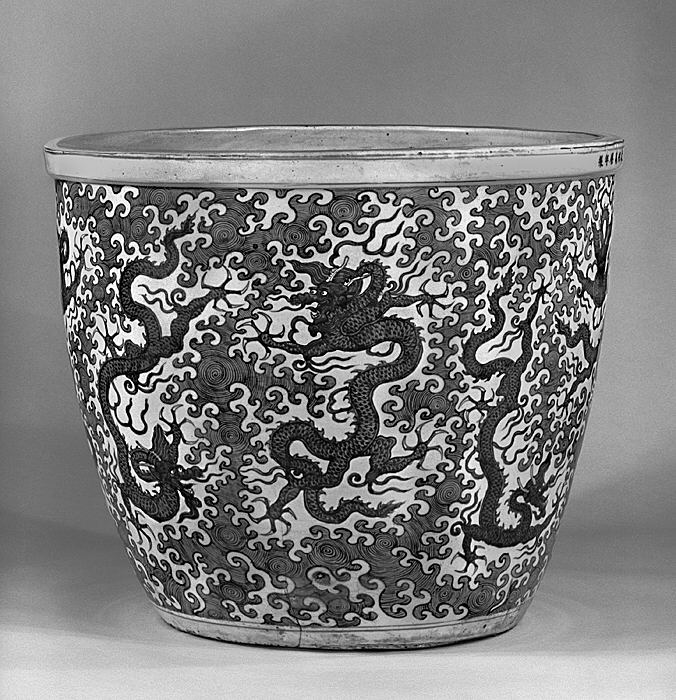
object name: jar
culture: chinese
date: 1573-1620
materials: porcelain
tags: dragons